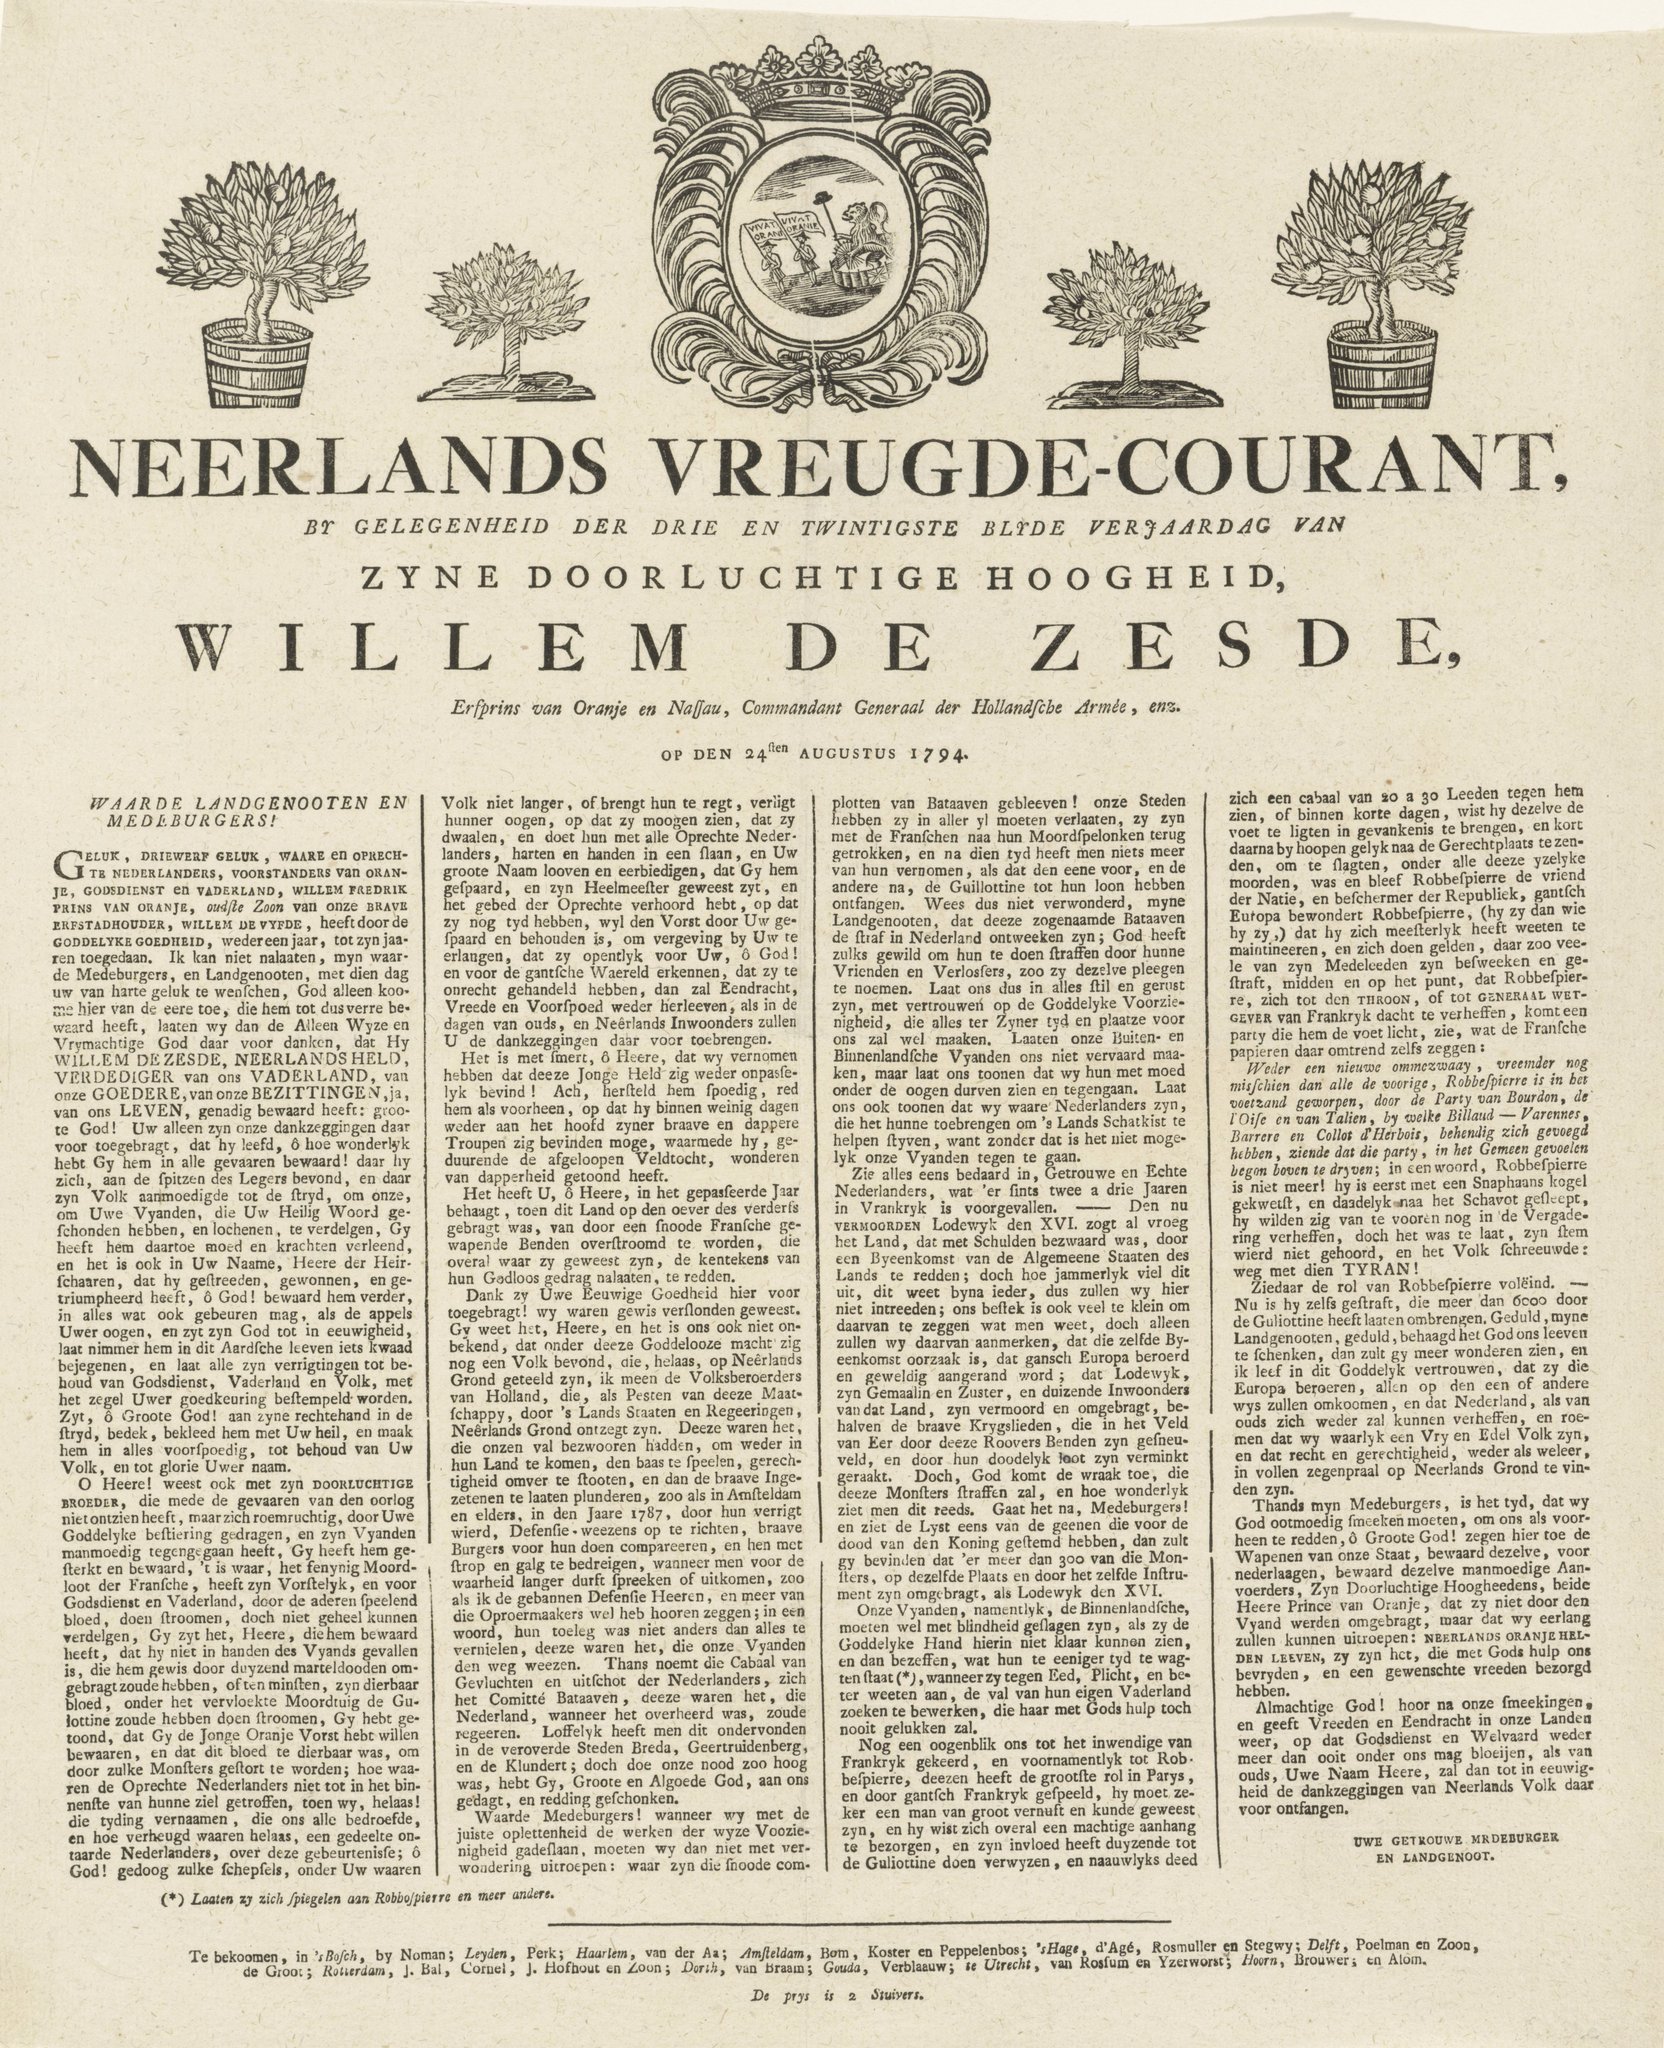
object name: text sheet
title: Vreugdecourant bij de 23ste verjaardag van prins Willem I Frederik, 1794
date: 1794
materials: paper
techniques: letterpress printing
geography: northern netherlands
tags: the hague, berlin, william i of the netherlands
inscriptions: collector's mark: Lugt 2228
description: Vreugdecourant ter gelegenheid van de 23ste verjaardag van prins Willem I Frederik, op 24 augustus 1794. Tekst in vier kolommen, bovenaan Oranjebomen en een centraal vignet. Onderaan een lijst van twintig uitgevers in verschillende steden waar het blad verkrijngbaar is.